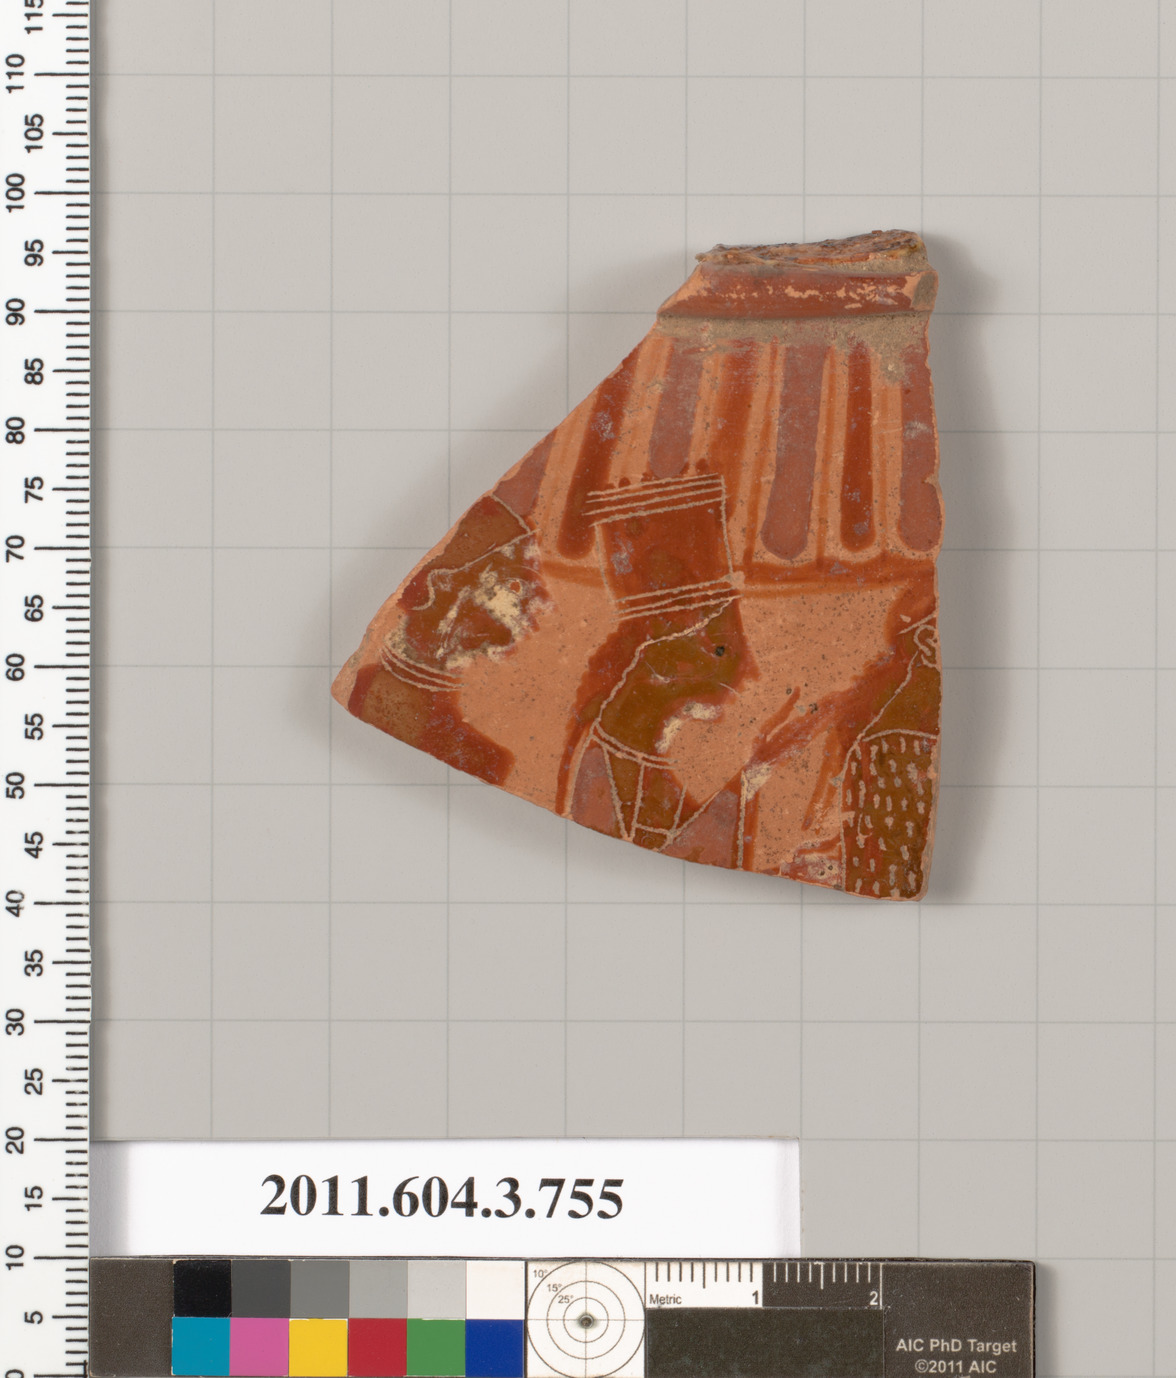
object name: neck amphora, tyrrhenian fragment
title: Terracotta fragment of a neck-amphora (jar)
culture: greek, attic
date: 575-551 BCE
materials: terracotta